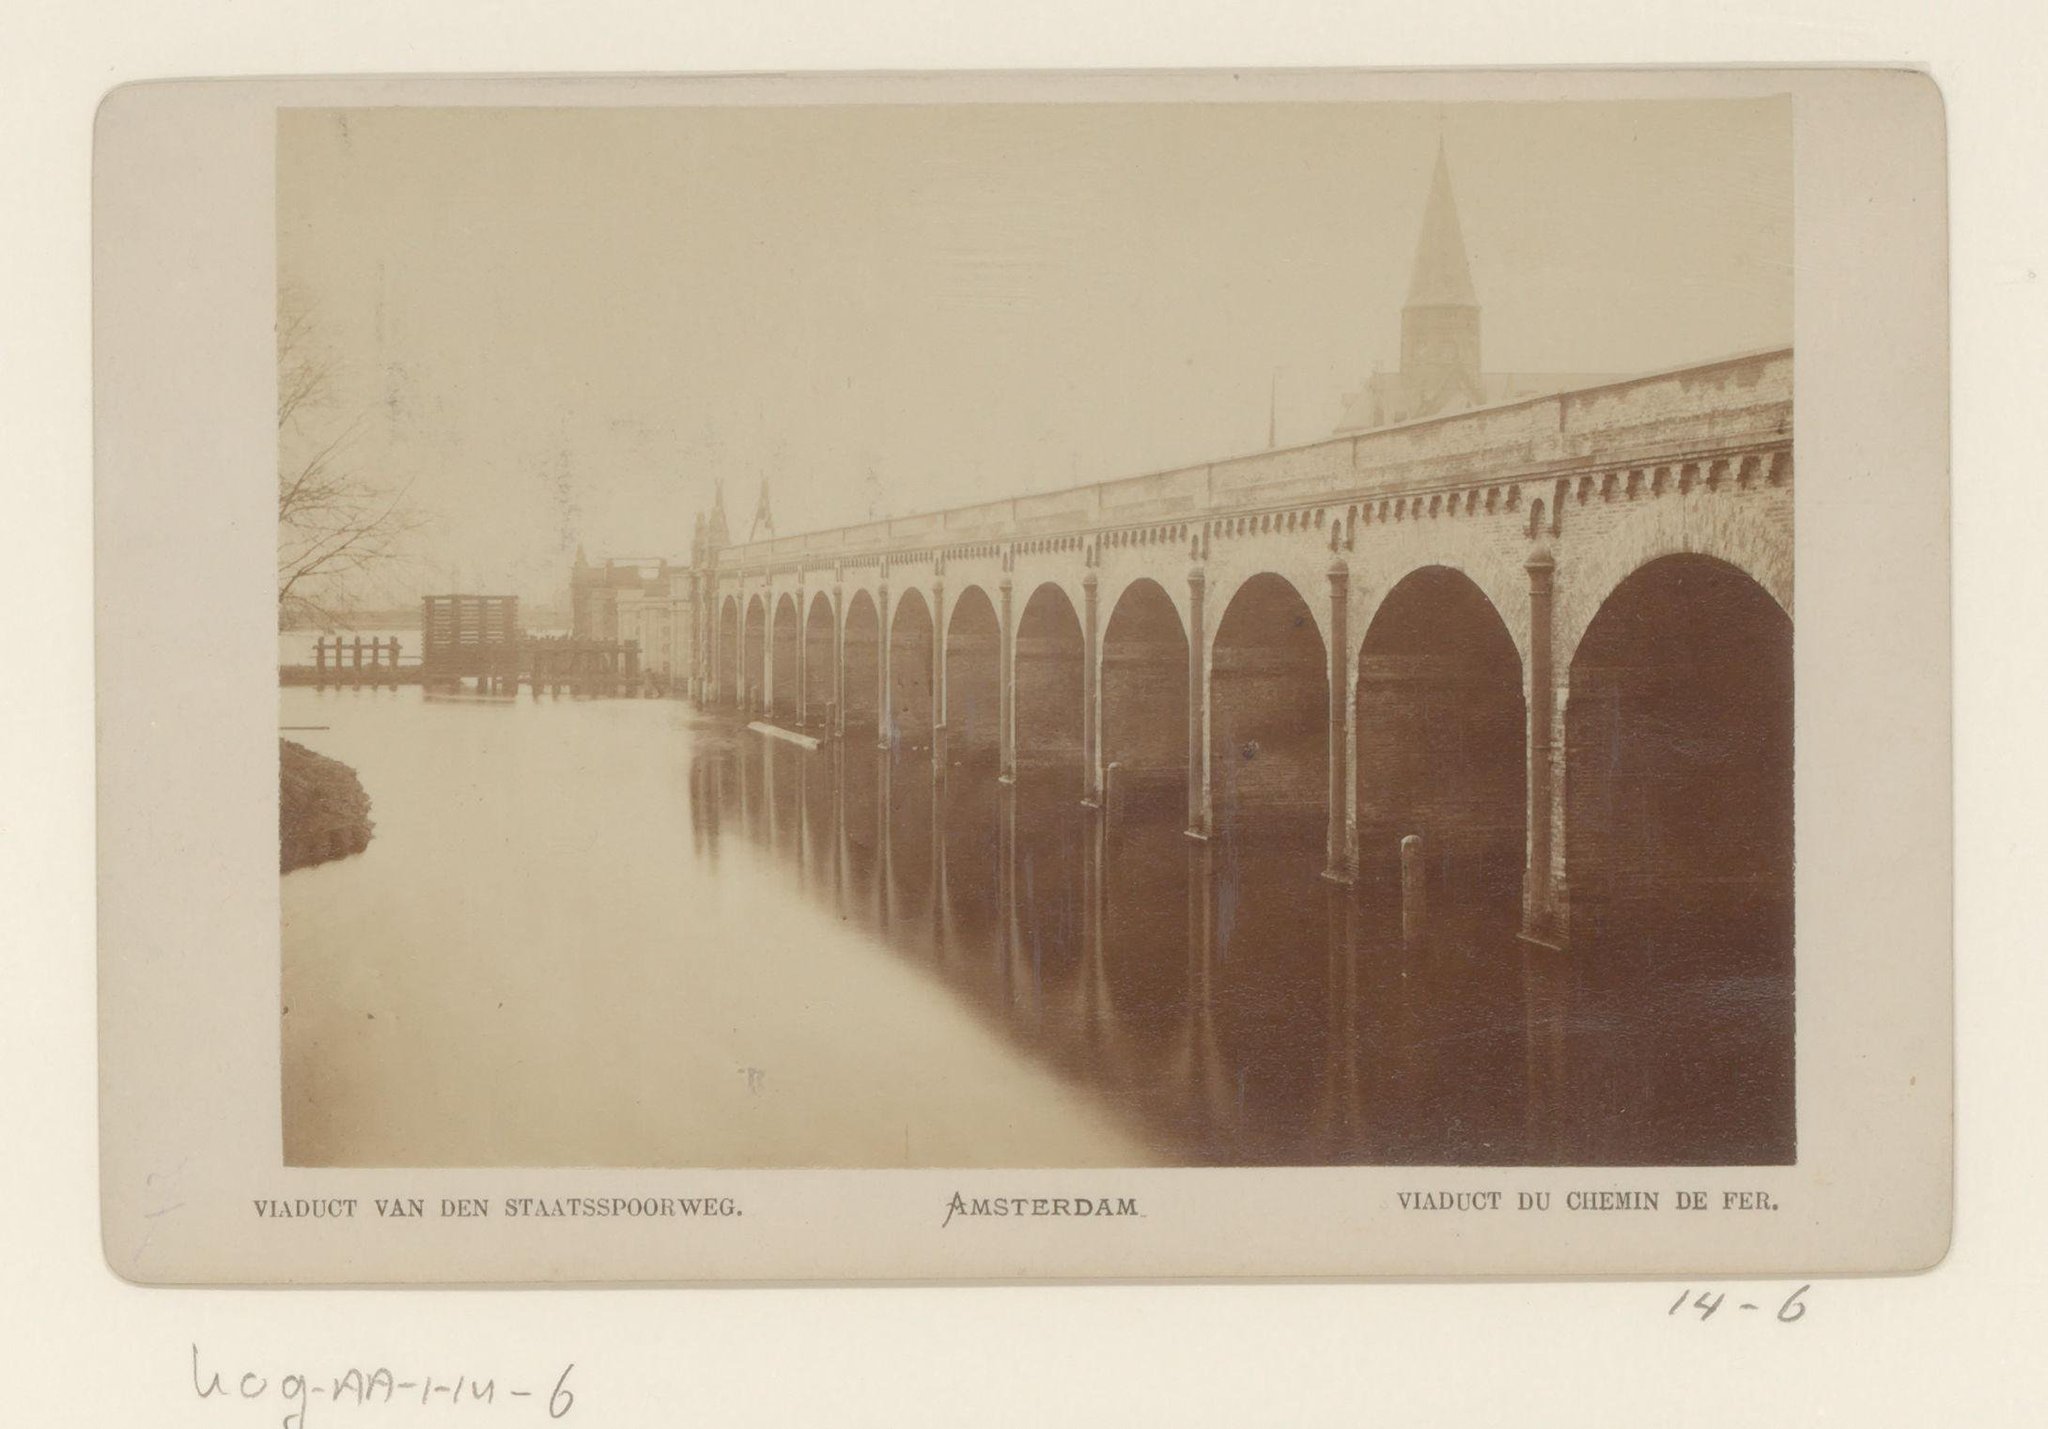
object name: cabinet photograph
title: Gezicht op het viaduct bij Station Amsterdam Centraal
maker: Anonymous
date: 1850-1915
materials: cardboard, paper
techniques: albumen print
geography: amsterdam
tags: viaduct, city-view in general; 'veduta', railway, train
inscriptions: collector's mark: ‘14.6’ Lugt 1641b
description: Onderwerpsrubriek binnen de Atlas Amsterdam: Verhulststraat (Johannes), Viaducten, Vierwindenstraat, Vinkenbuurt, Vinkenpad, Vinkenstraat, Vischsteeg, Vliegendesteeg, Voetboogstraat, Volewijk, Vondelstraat, Voorburgwal (N.Z.).